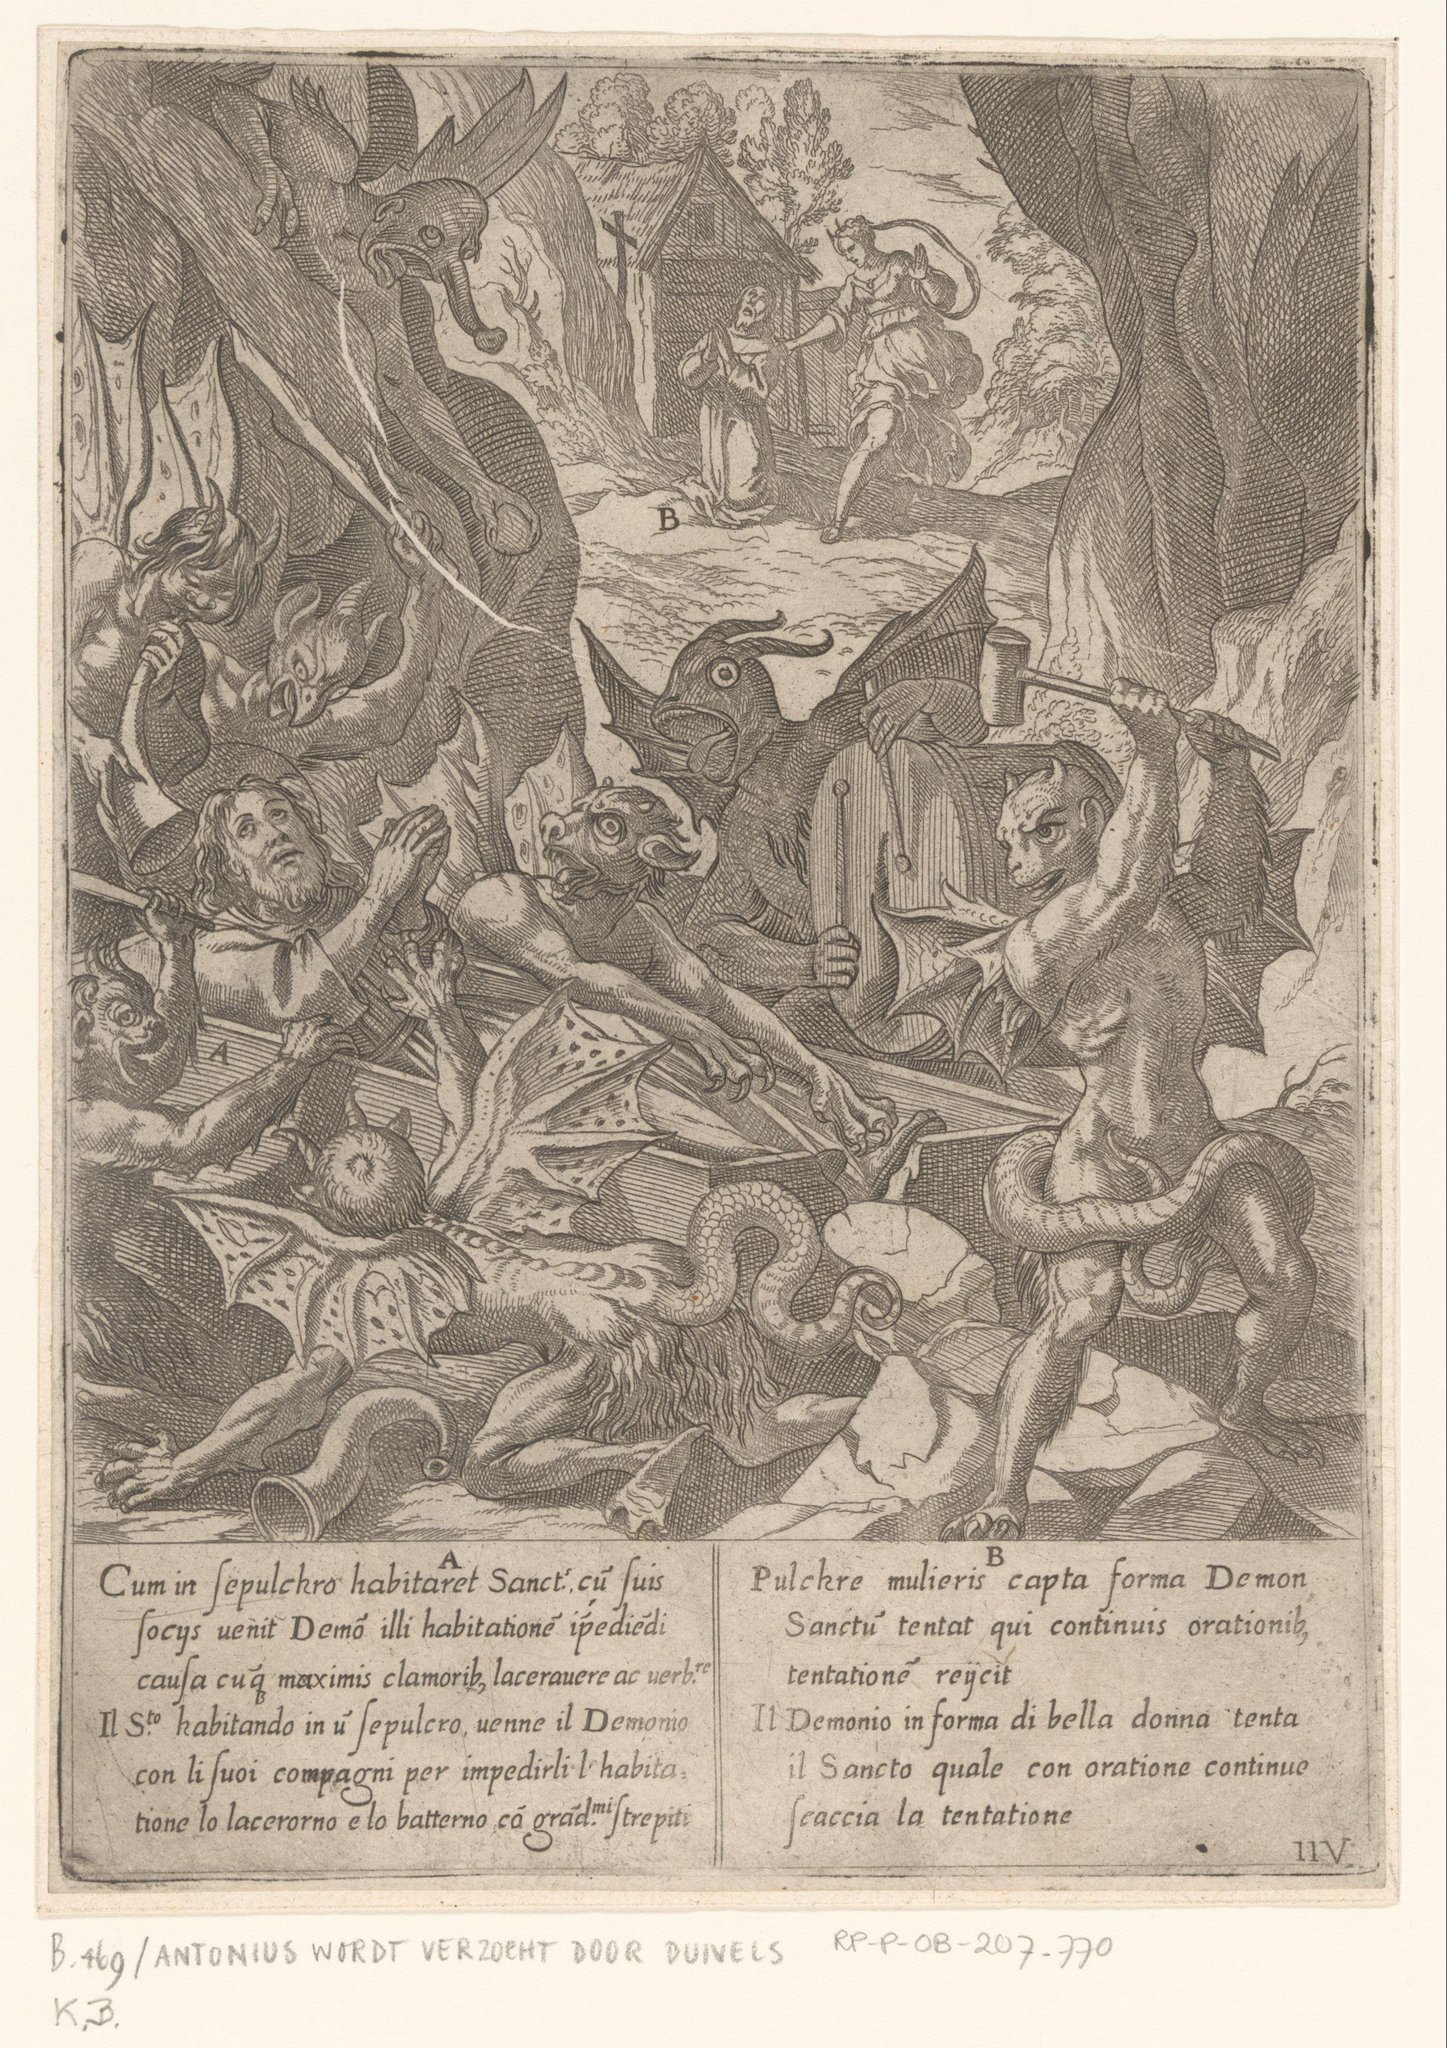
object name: print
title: Het leven van de heilige Antonius de Grote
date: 1598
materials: paper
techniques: etching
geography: rome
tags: devil(s) and demons, temptations of st. antony abbot, the hermit antony abbot (antonius abbas) of egypt, also called the great; possible attributes: bell, book, t-shaped staff, flames, pig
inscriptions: collector's mark: Lugt 240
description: Deze prent maakt deel uit van een reeks van 27 prenten (+ titelprent) over het leven van de heilige Antonius, naar een frescocyclus in de S. Antonio Abbate in Rome door Giovanni Battista Lombardelli en Niccolò Circignani.